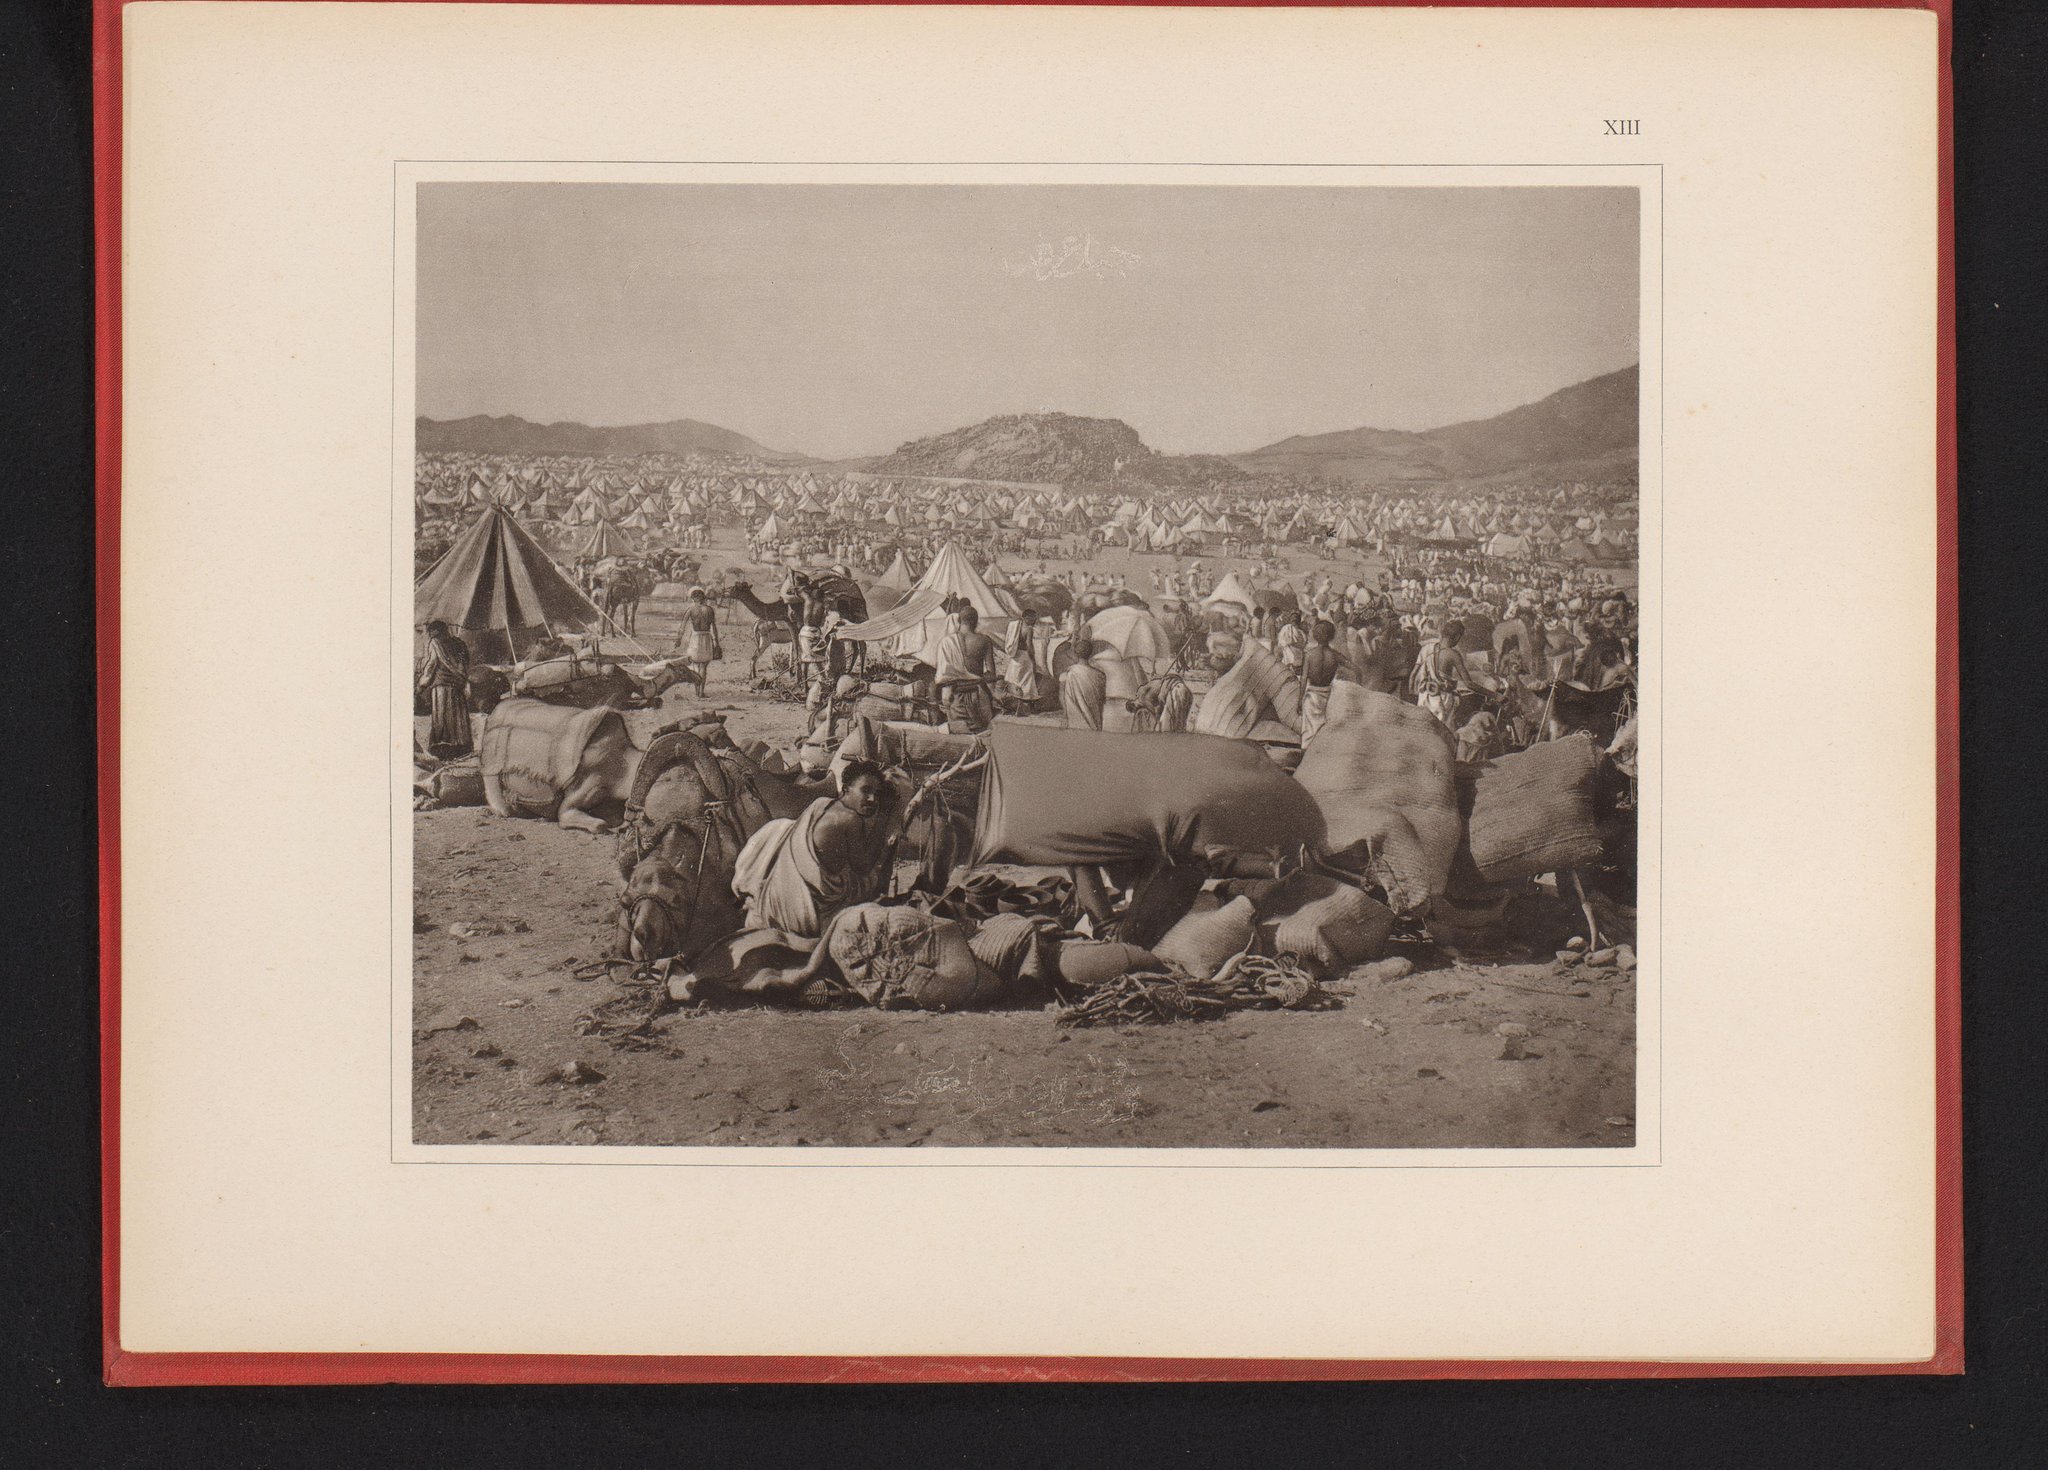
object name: album leaf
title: Der Berg Arafah während der jährlichen Pilgerversammlung (von Süden aus gesehen)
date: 1889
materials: cardboard, paper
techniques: photograph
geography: arafat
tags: other ritual practices ~ islam, mohammedanism, tent-camp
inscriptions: number: ‘XIII’